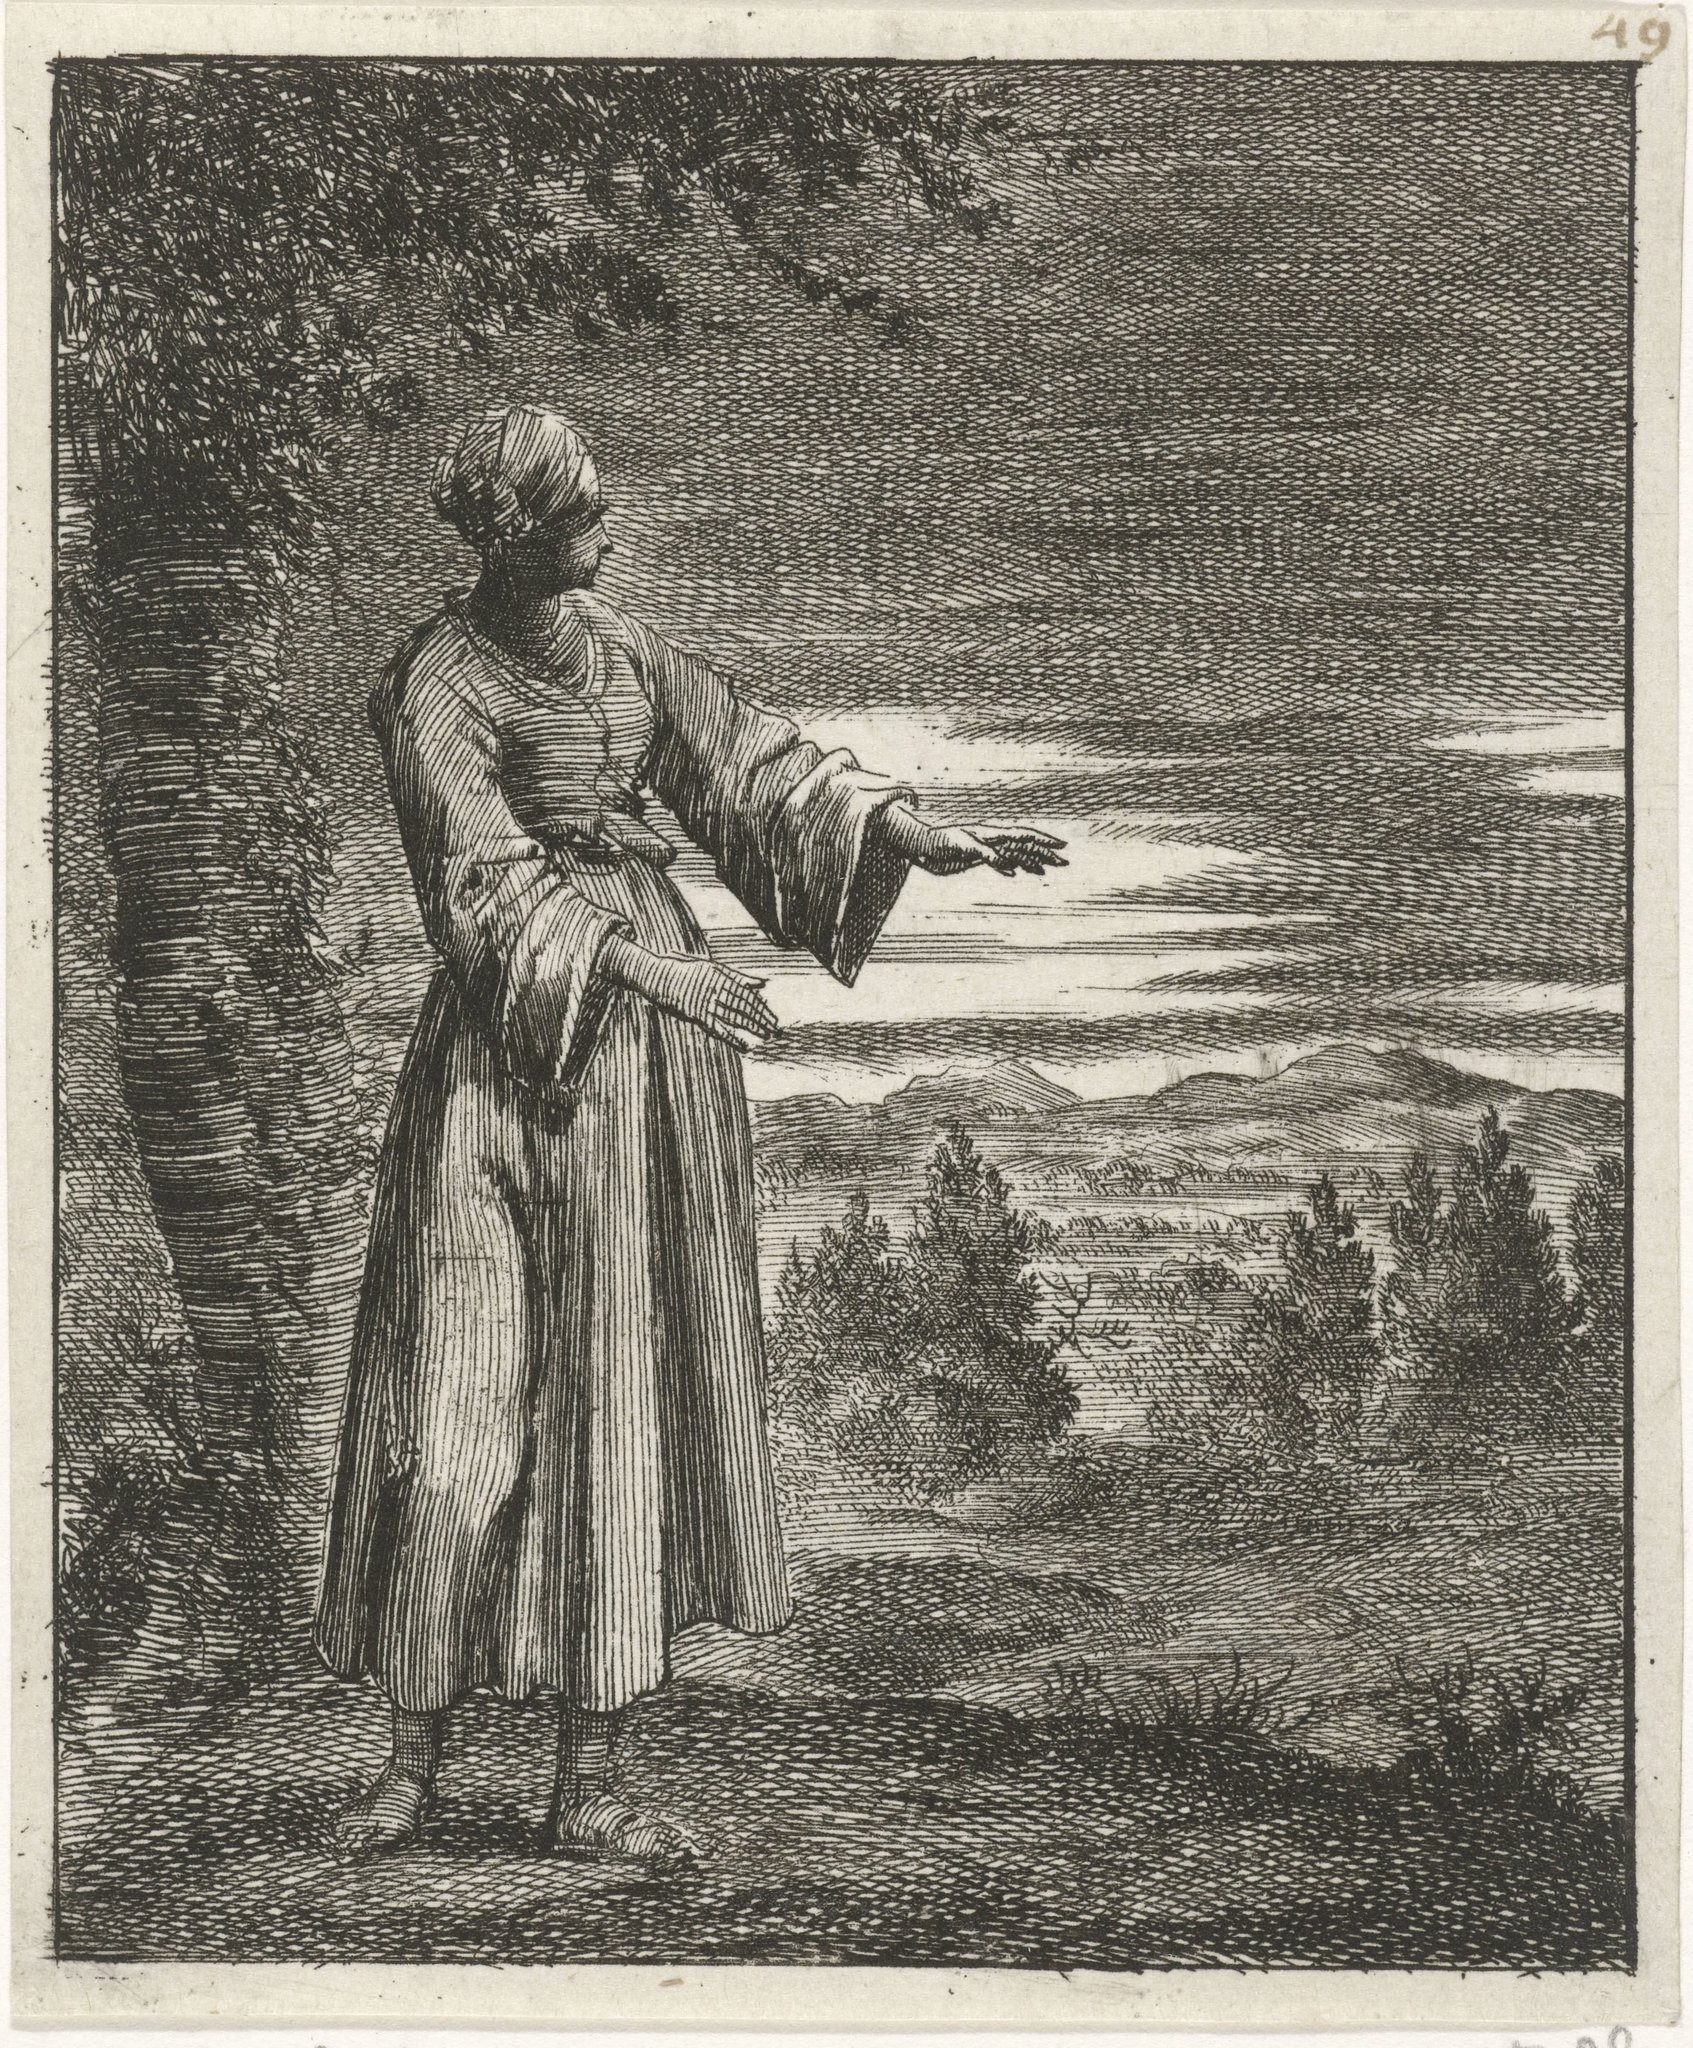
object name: print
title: Vrouw wandelend in de nacht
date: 1687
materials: paper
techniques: etching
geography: amsterdam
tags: walking, hiking (recreation), night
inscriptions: number: ‘49’, collector's mark: Lugt 2228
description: Illustratie uit: Luyken, Jan. Voncken der liefde Jesu, van het godtbegerende zielenvier. Amsterdam: Pieter Arentsz (II), 1687, p. 206.